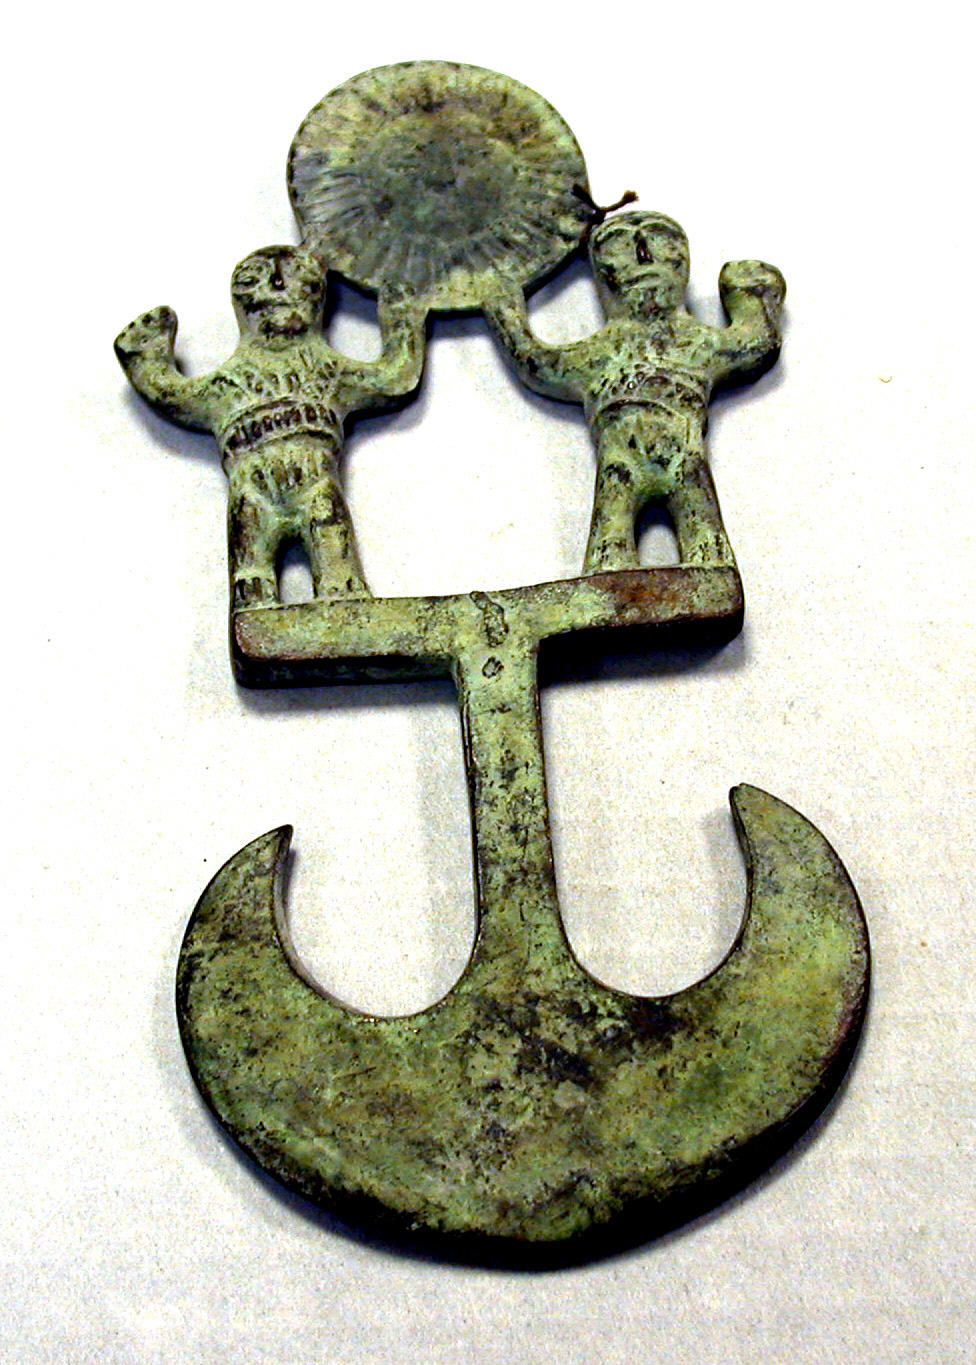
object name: ornament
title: Cast Copper Crescent Ornament with Figures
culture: peruvian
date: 1501-1700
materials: copper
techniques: casting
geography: peru